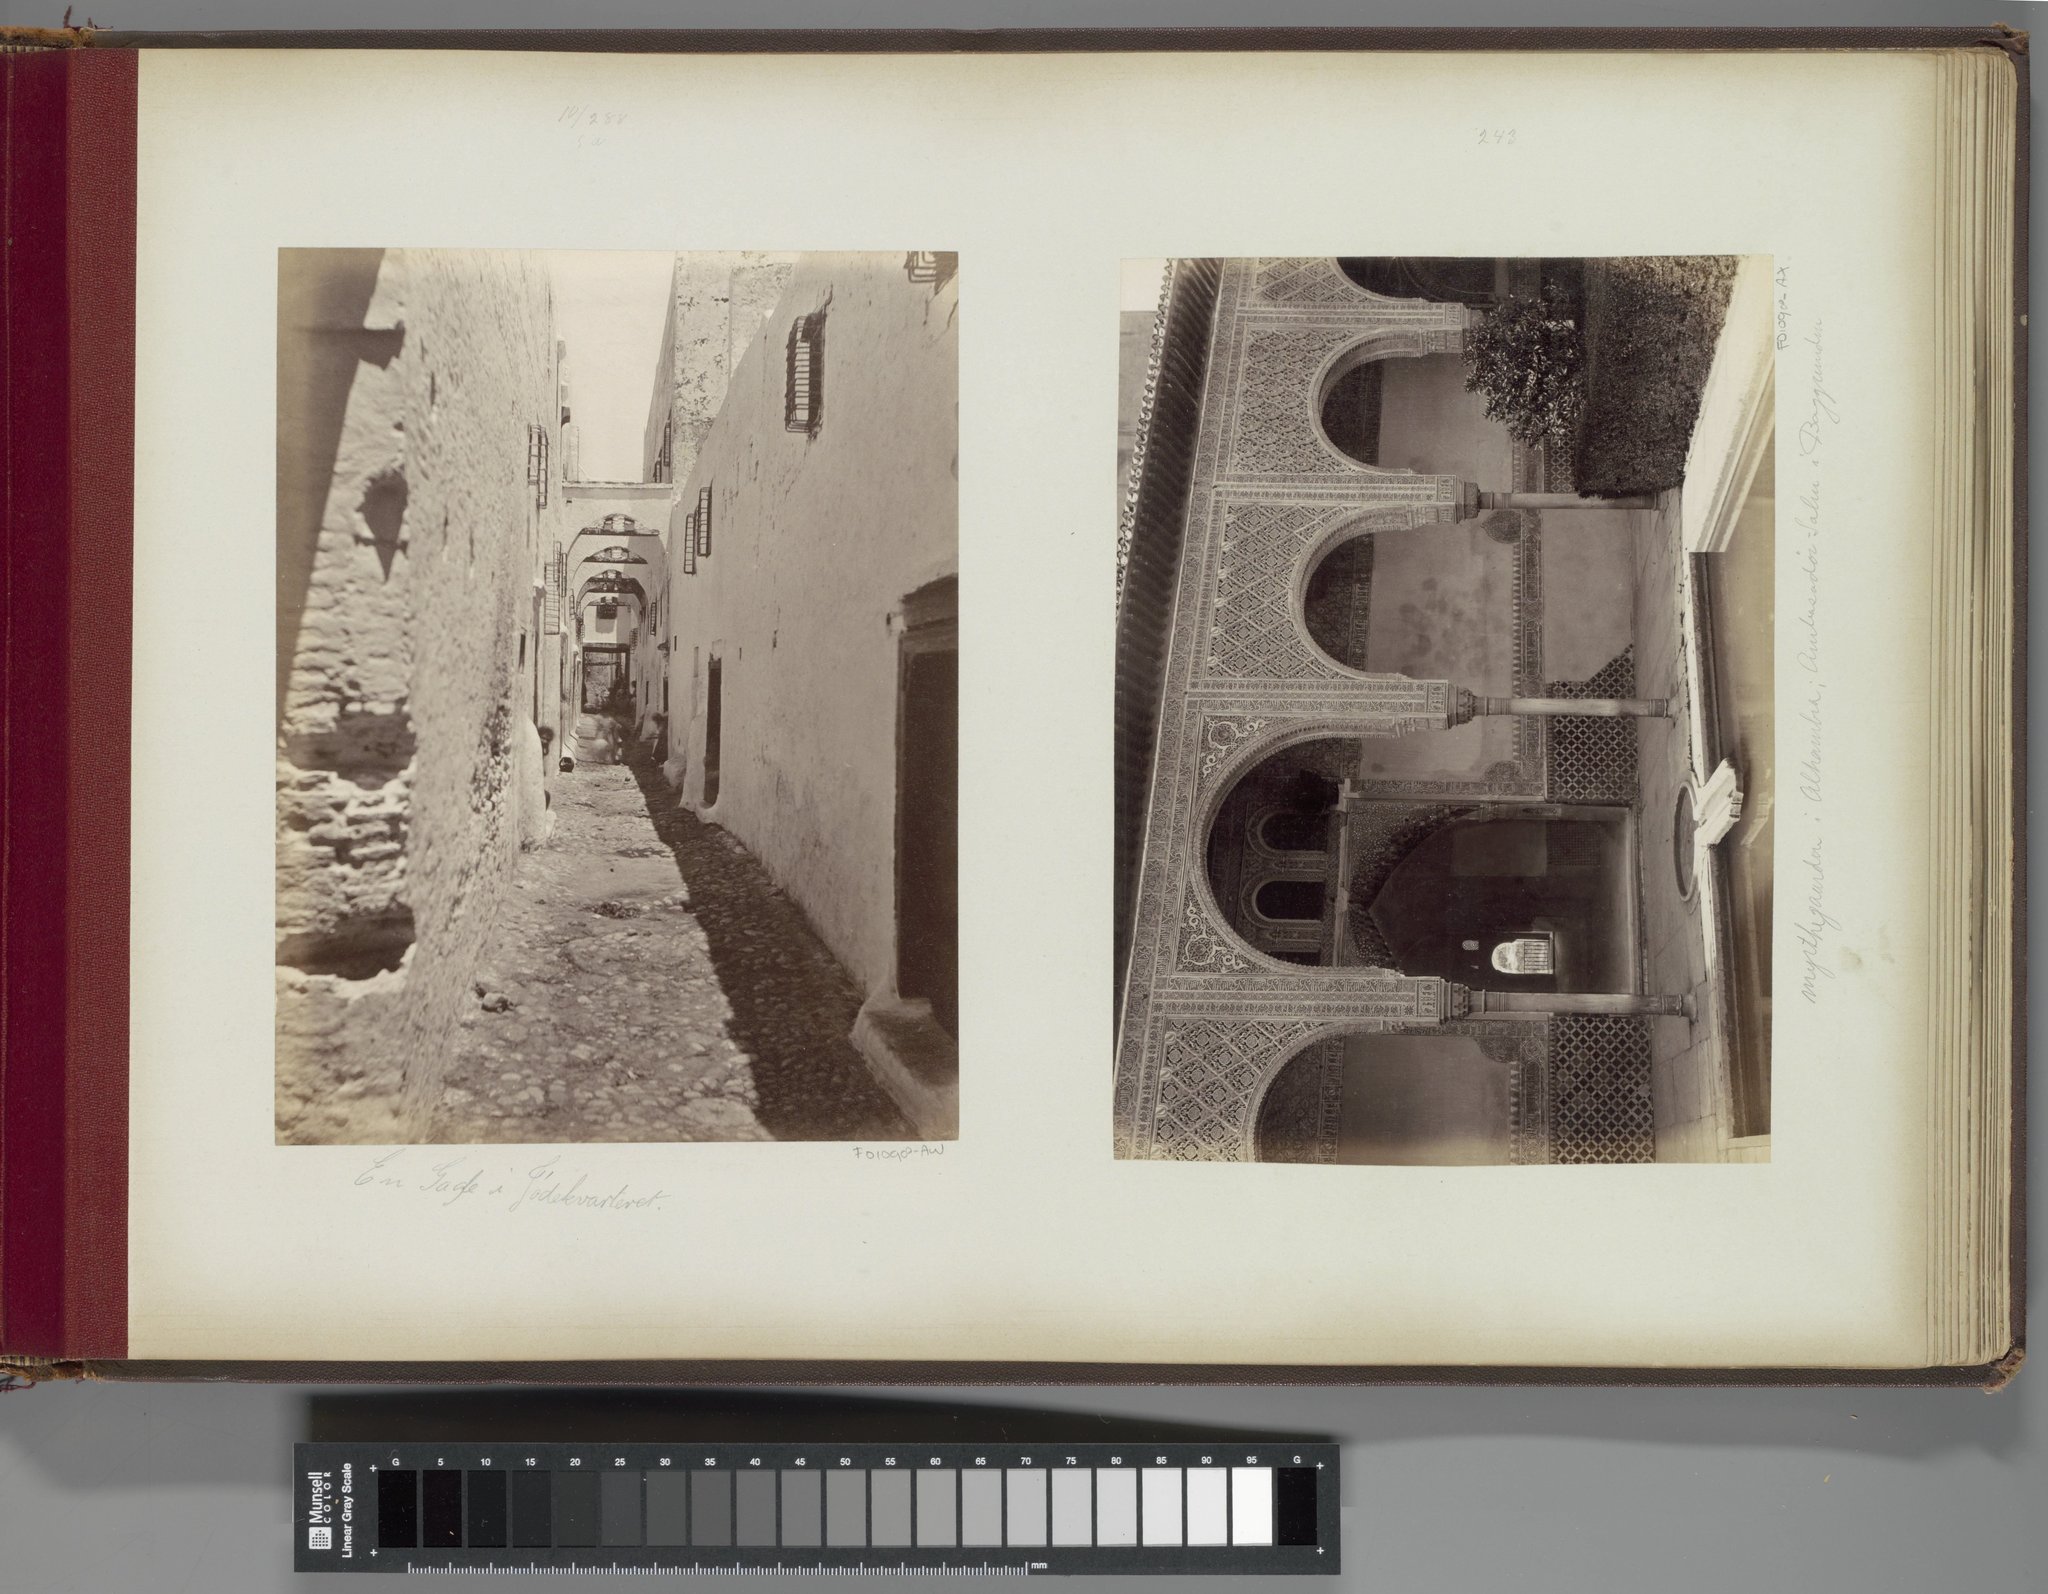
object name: photograph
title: Straat in de Joodse wijk van Granada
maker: Anonymous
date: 1860-1880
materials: cardboard, paper, photographic support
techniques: albumen print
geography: granada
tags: lane, alley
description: Onderdeel van Reisalbum met foto's van bezienswaardigheden in Spanje en Marokko.